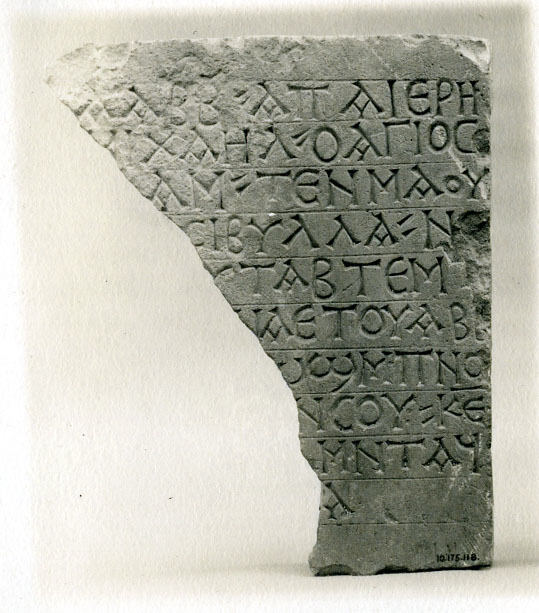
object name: fragment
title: Fragment of an Inscribed Stele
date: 501-700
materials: limestone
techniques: incising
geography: egypt